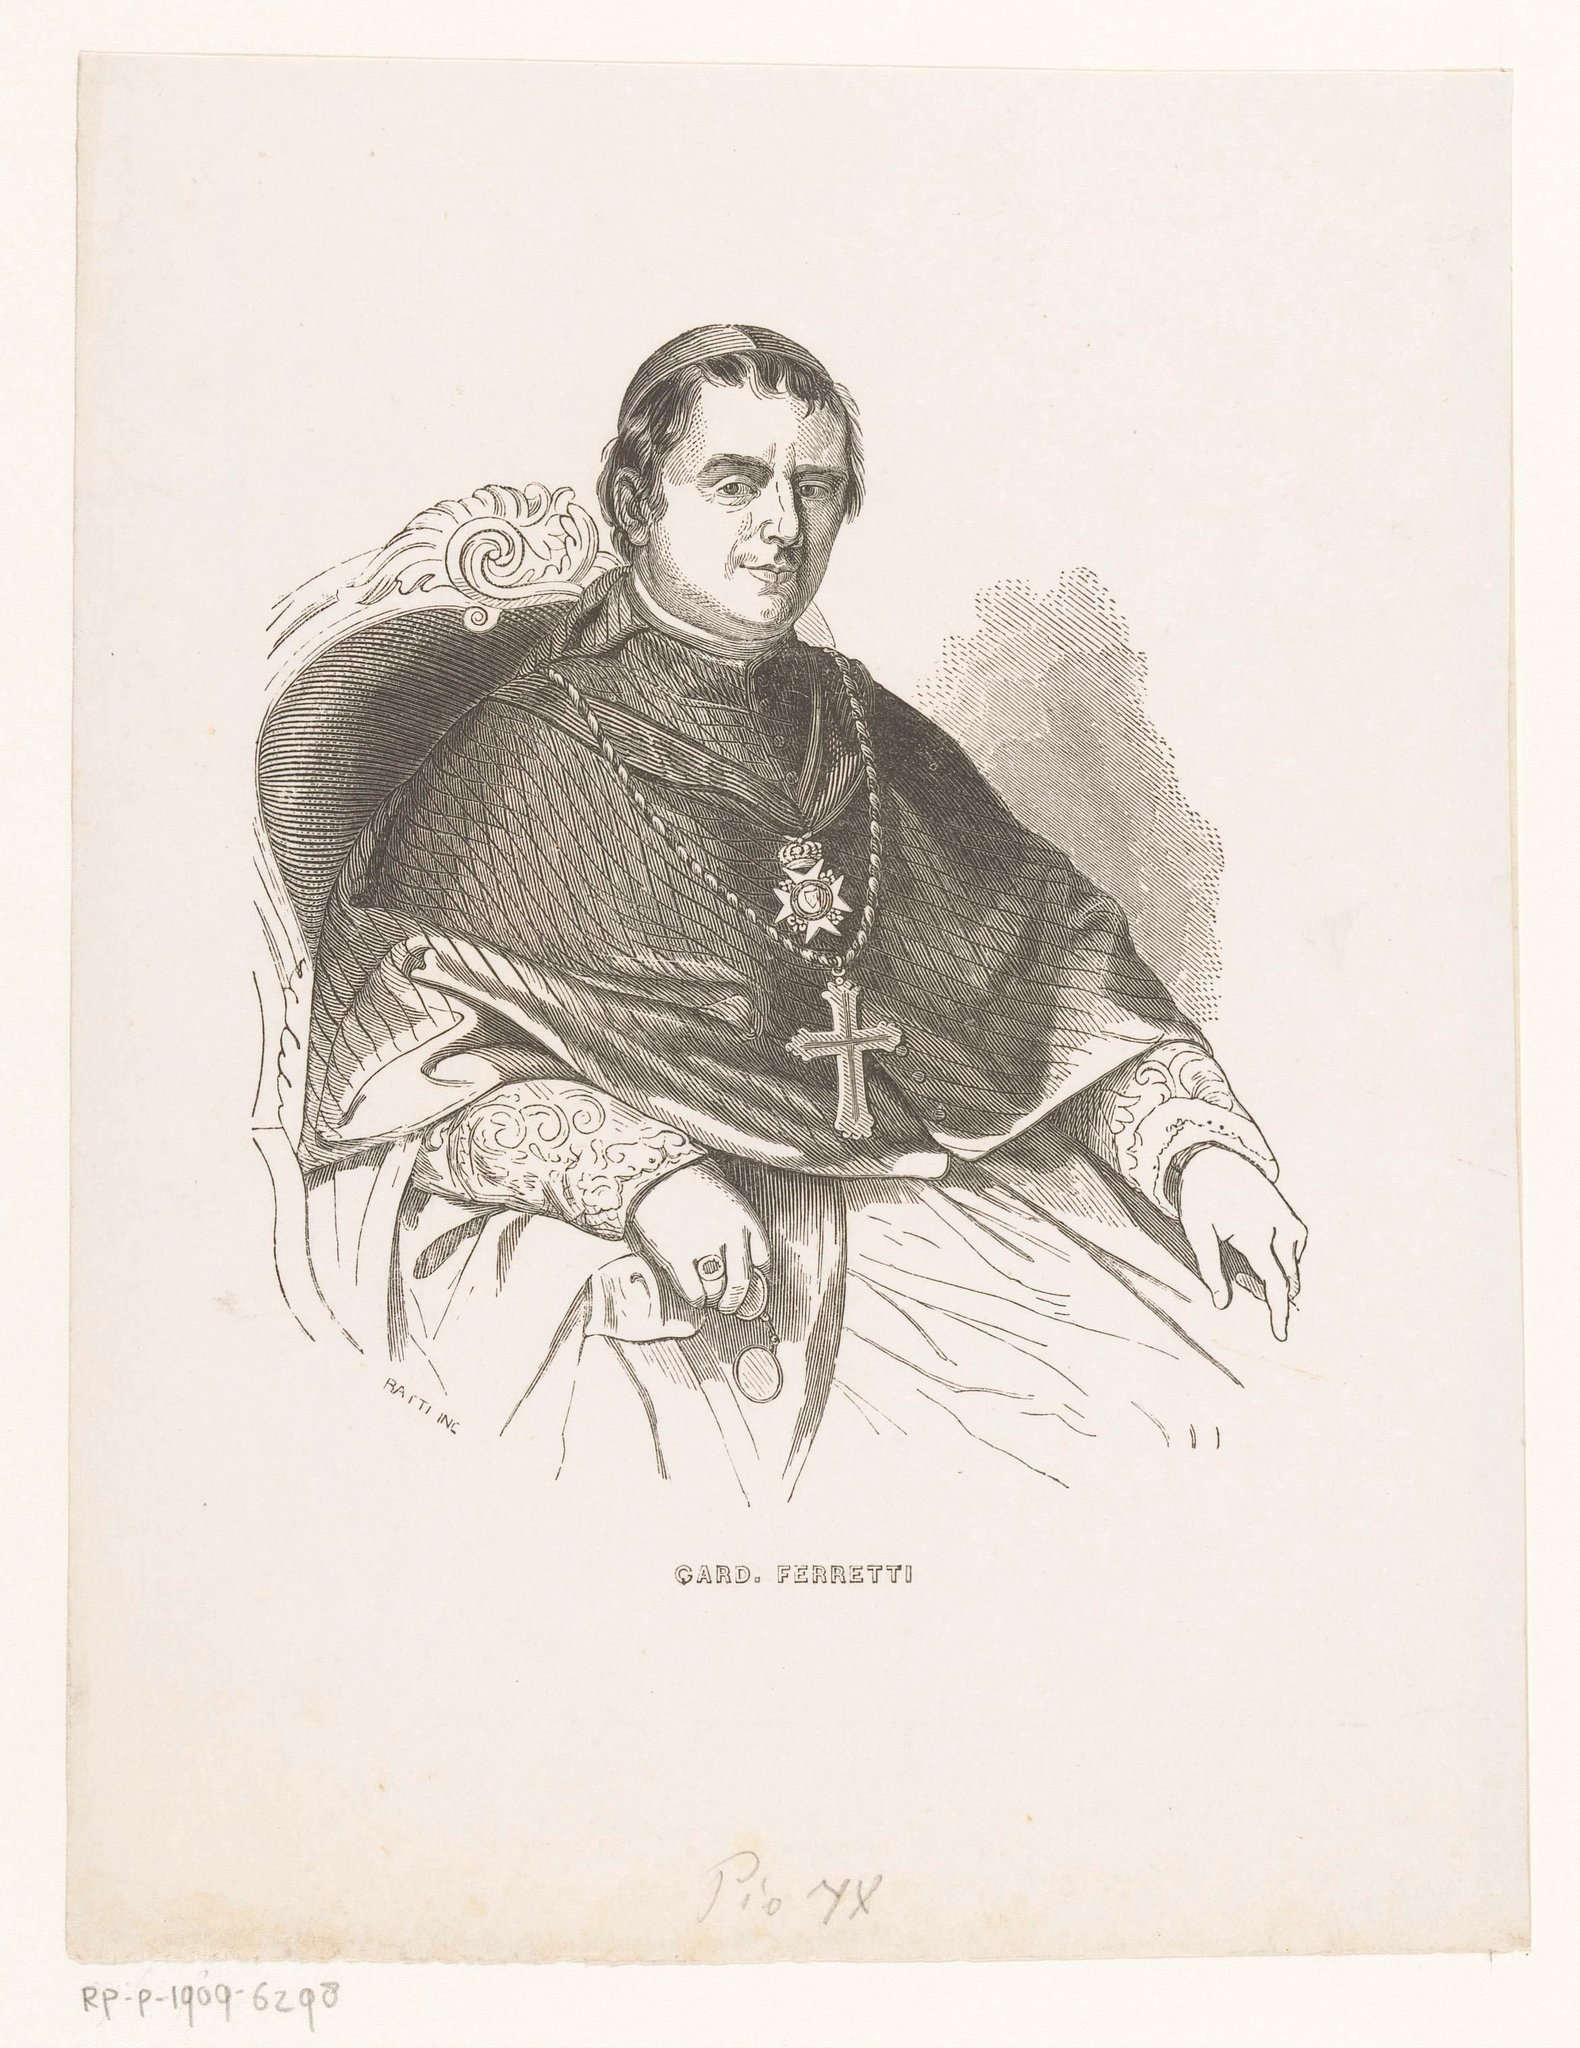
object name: print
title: Portret van kardinaal Gabriele Ferretti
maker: francesco ratti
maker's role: print maker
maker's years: 1819-1895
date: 1829-1895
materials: paper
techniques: engraving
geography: italy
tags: rome, cardinal, historical persons